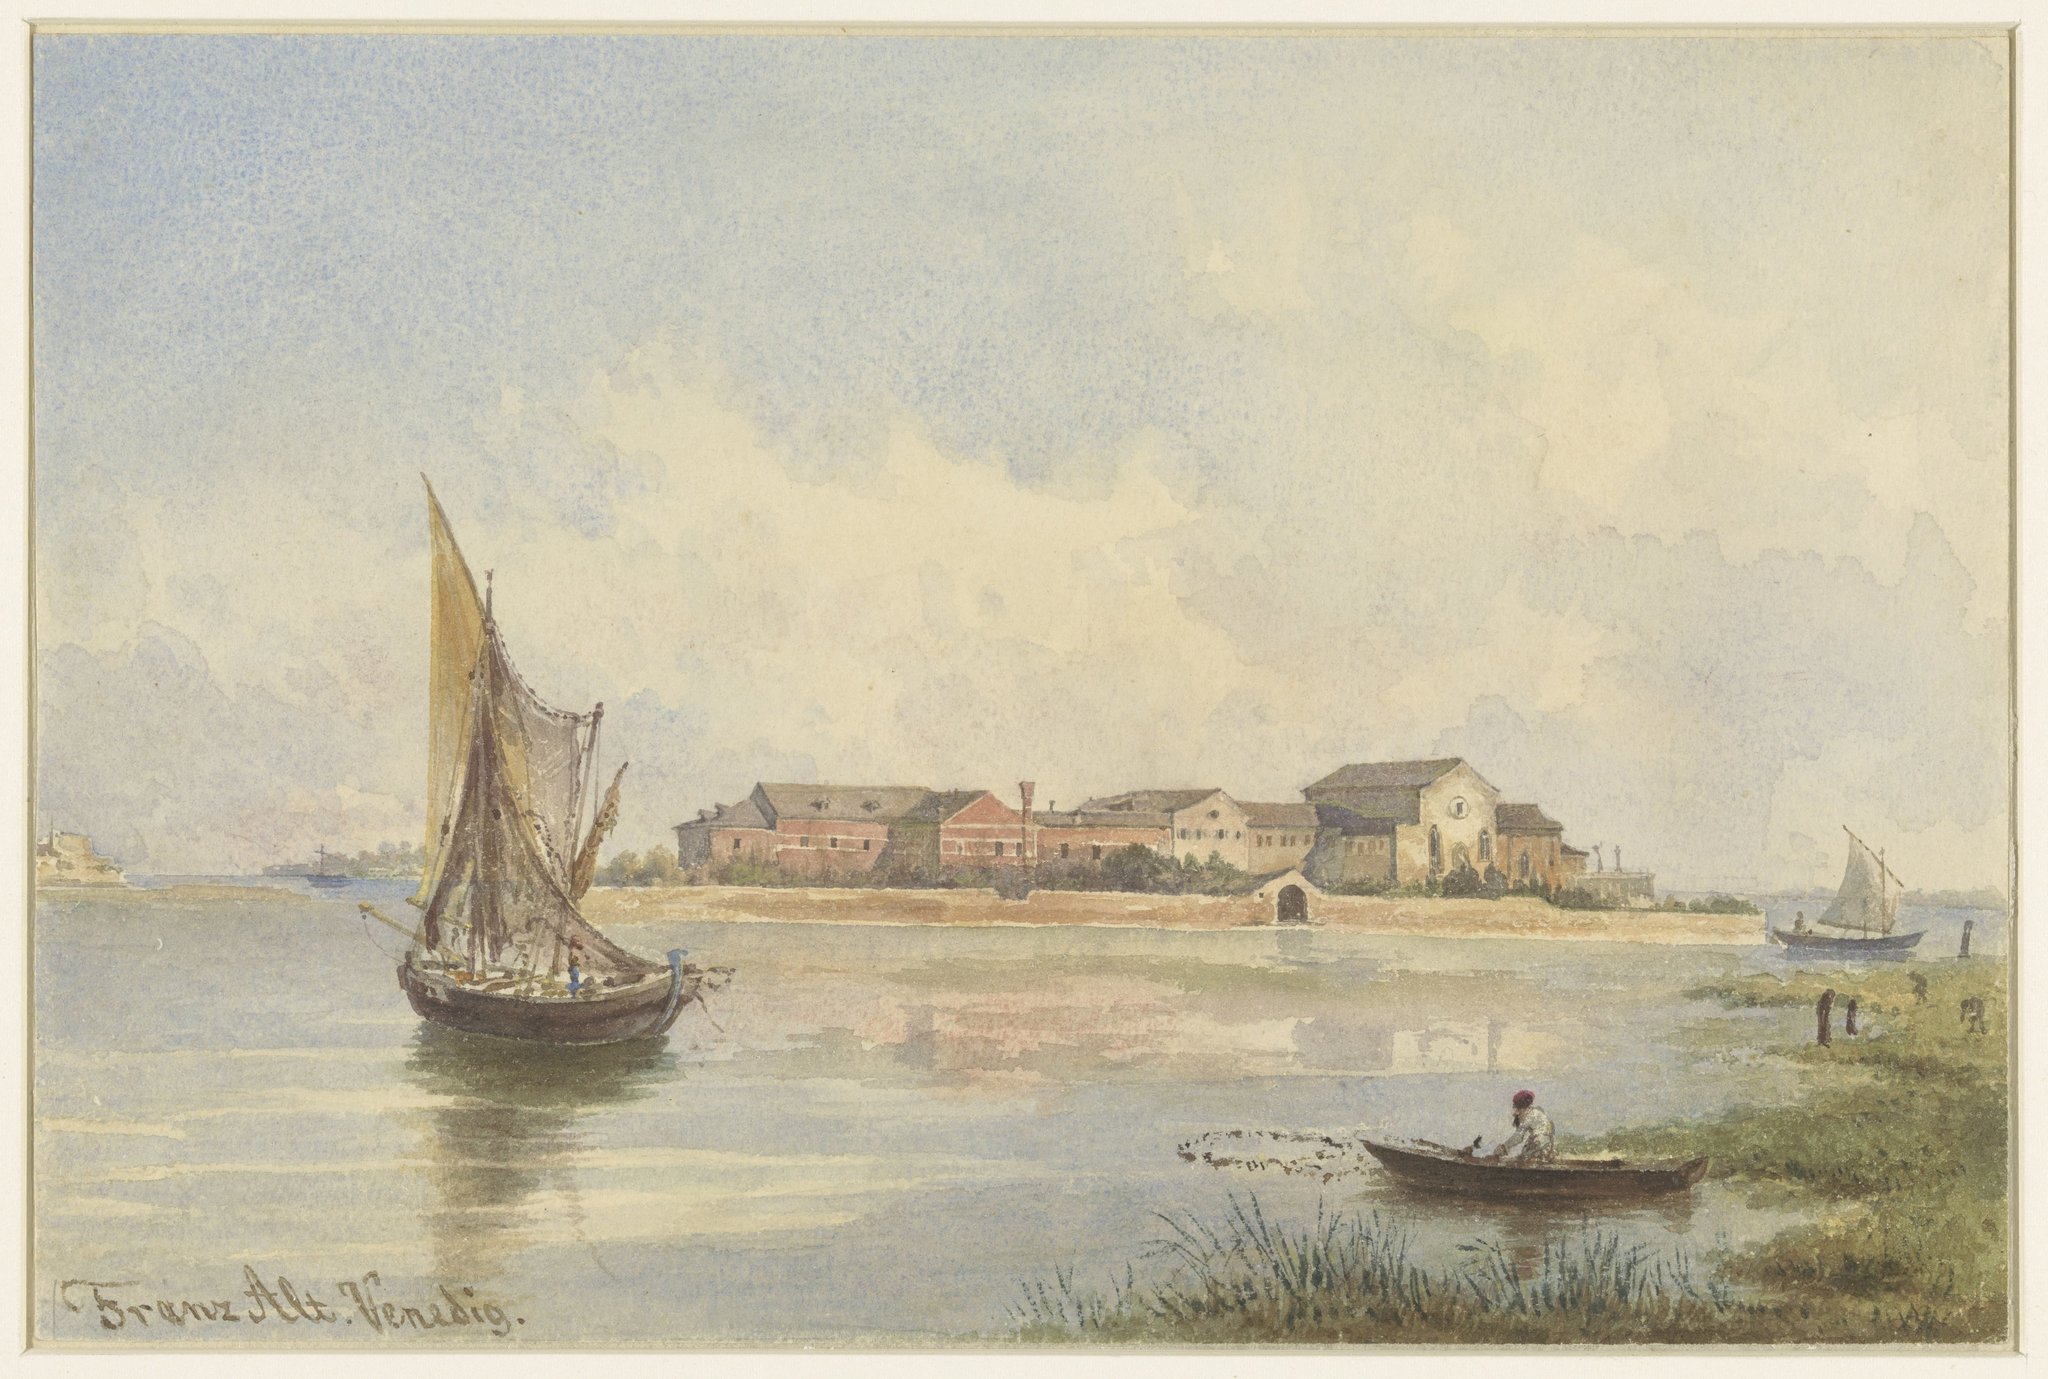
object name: drawing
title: Gezicht op de Lagune te Venetië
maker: franz alt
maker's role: draughtsman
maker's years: 1821-1914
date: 1831-1914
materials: paper, watercolor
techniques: brush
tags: outskirts of city (+ city (-scape) with figures, staffage), canals, waters (in city) (+ city(-scape) with figures, staffage), venice